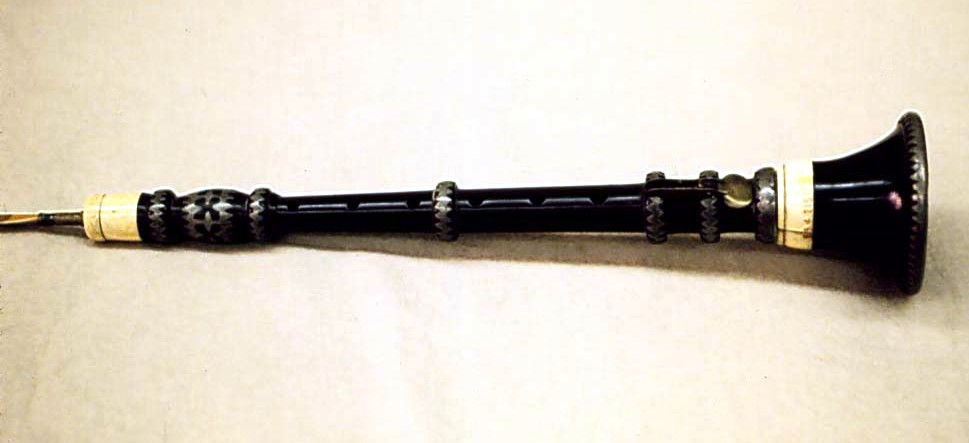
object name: shawm in b flat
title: Shawm in B-flat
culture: european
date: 1801-1833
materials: bone, brass, lead, pewter, wood